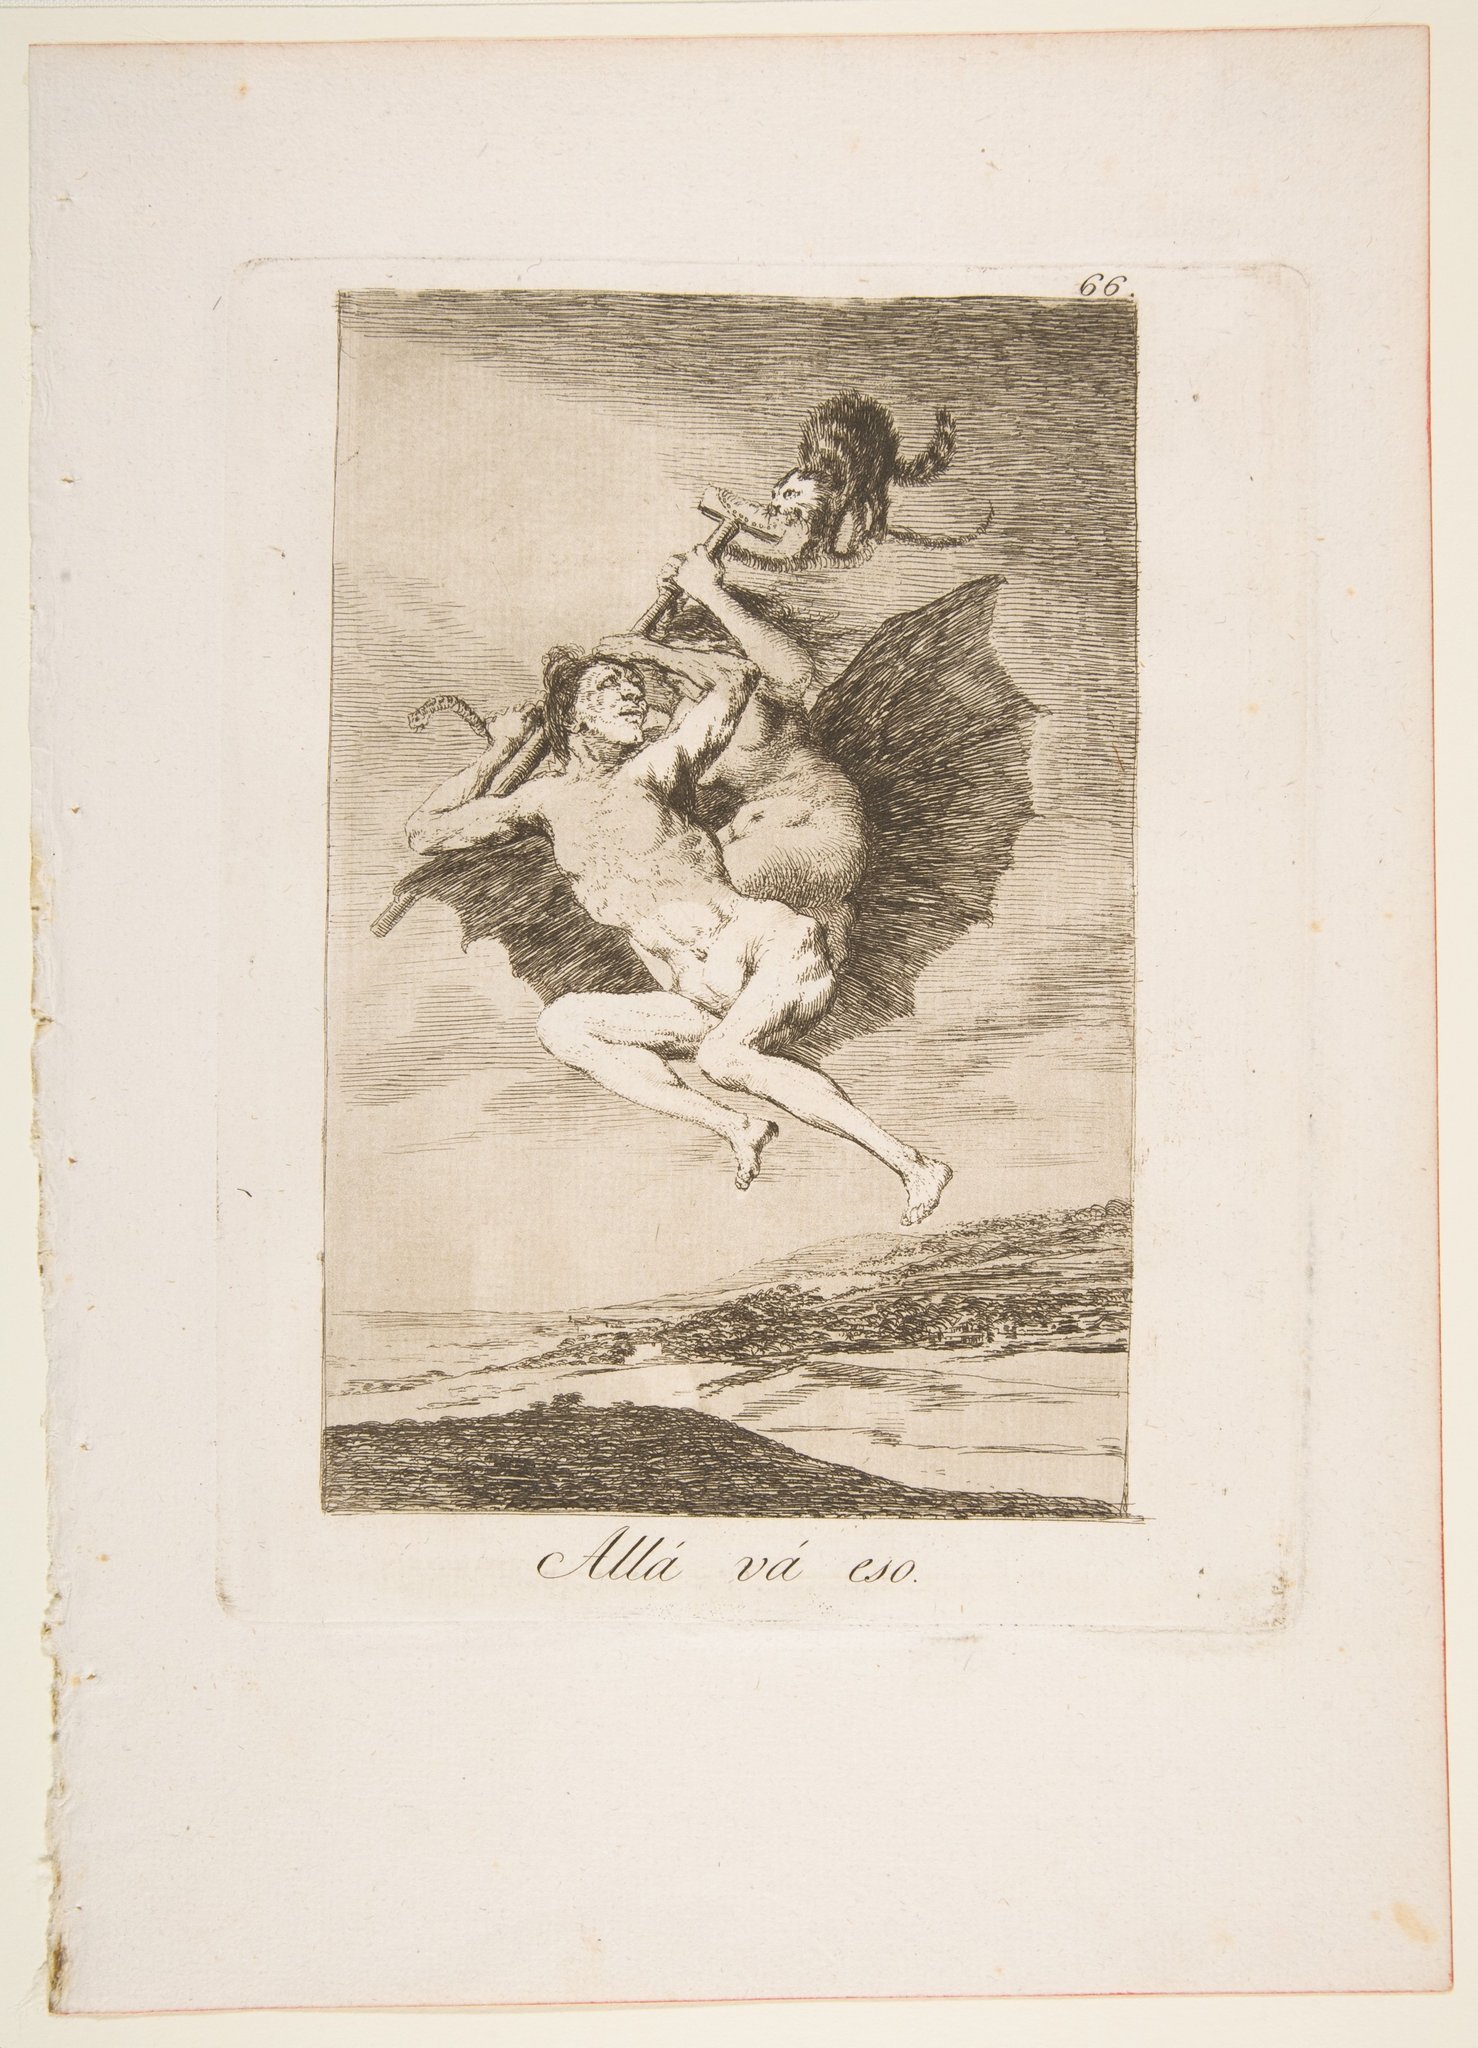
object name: print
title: Plate 66 from "Los Caprichos": There it goes (Allá vá eso)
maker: goya (francisco de goya y lucientes)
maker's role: artist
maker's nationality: spanish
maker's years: 1746-1828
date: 1799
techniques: aquatint, drypoint, etching